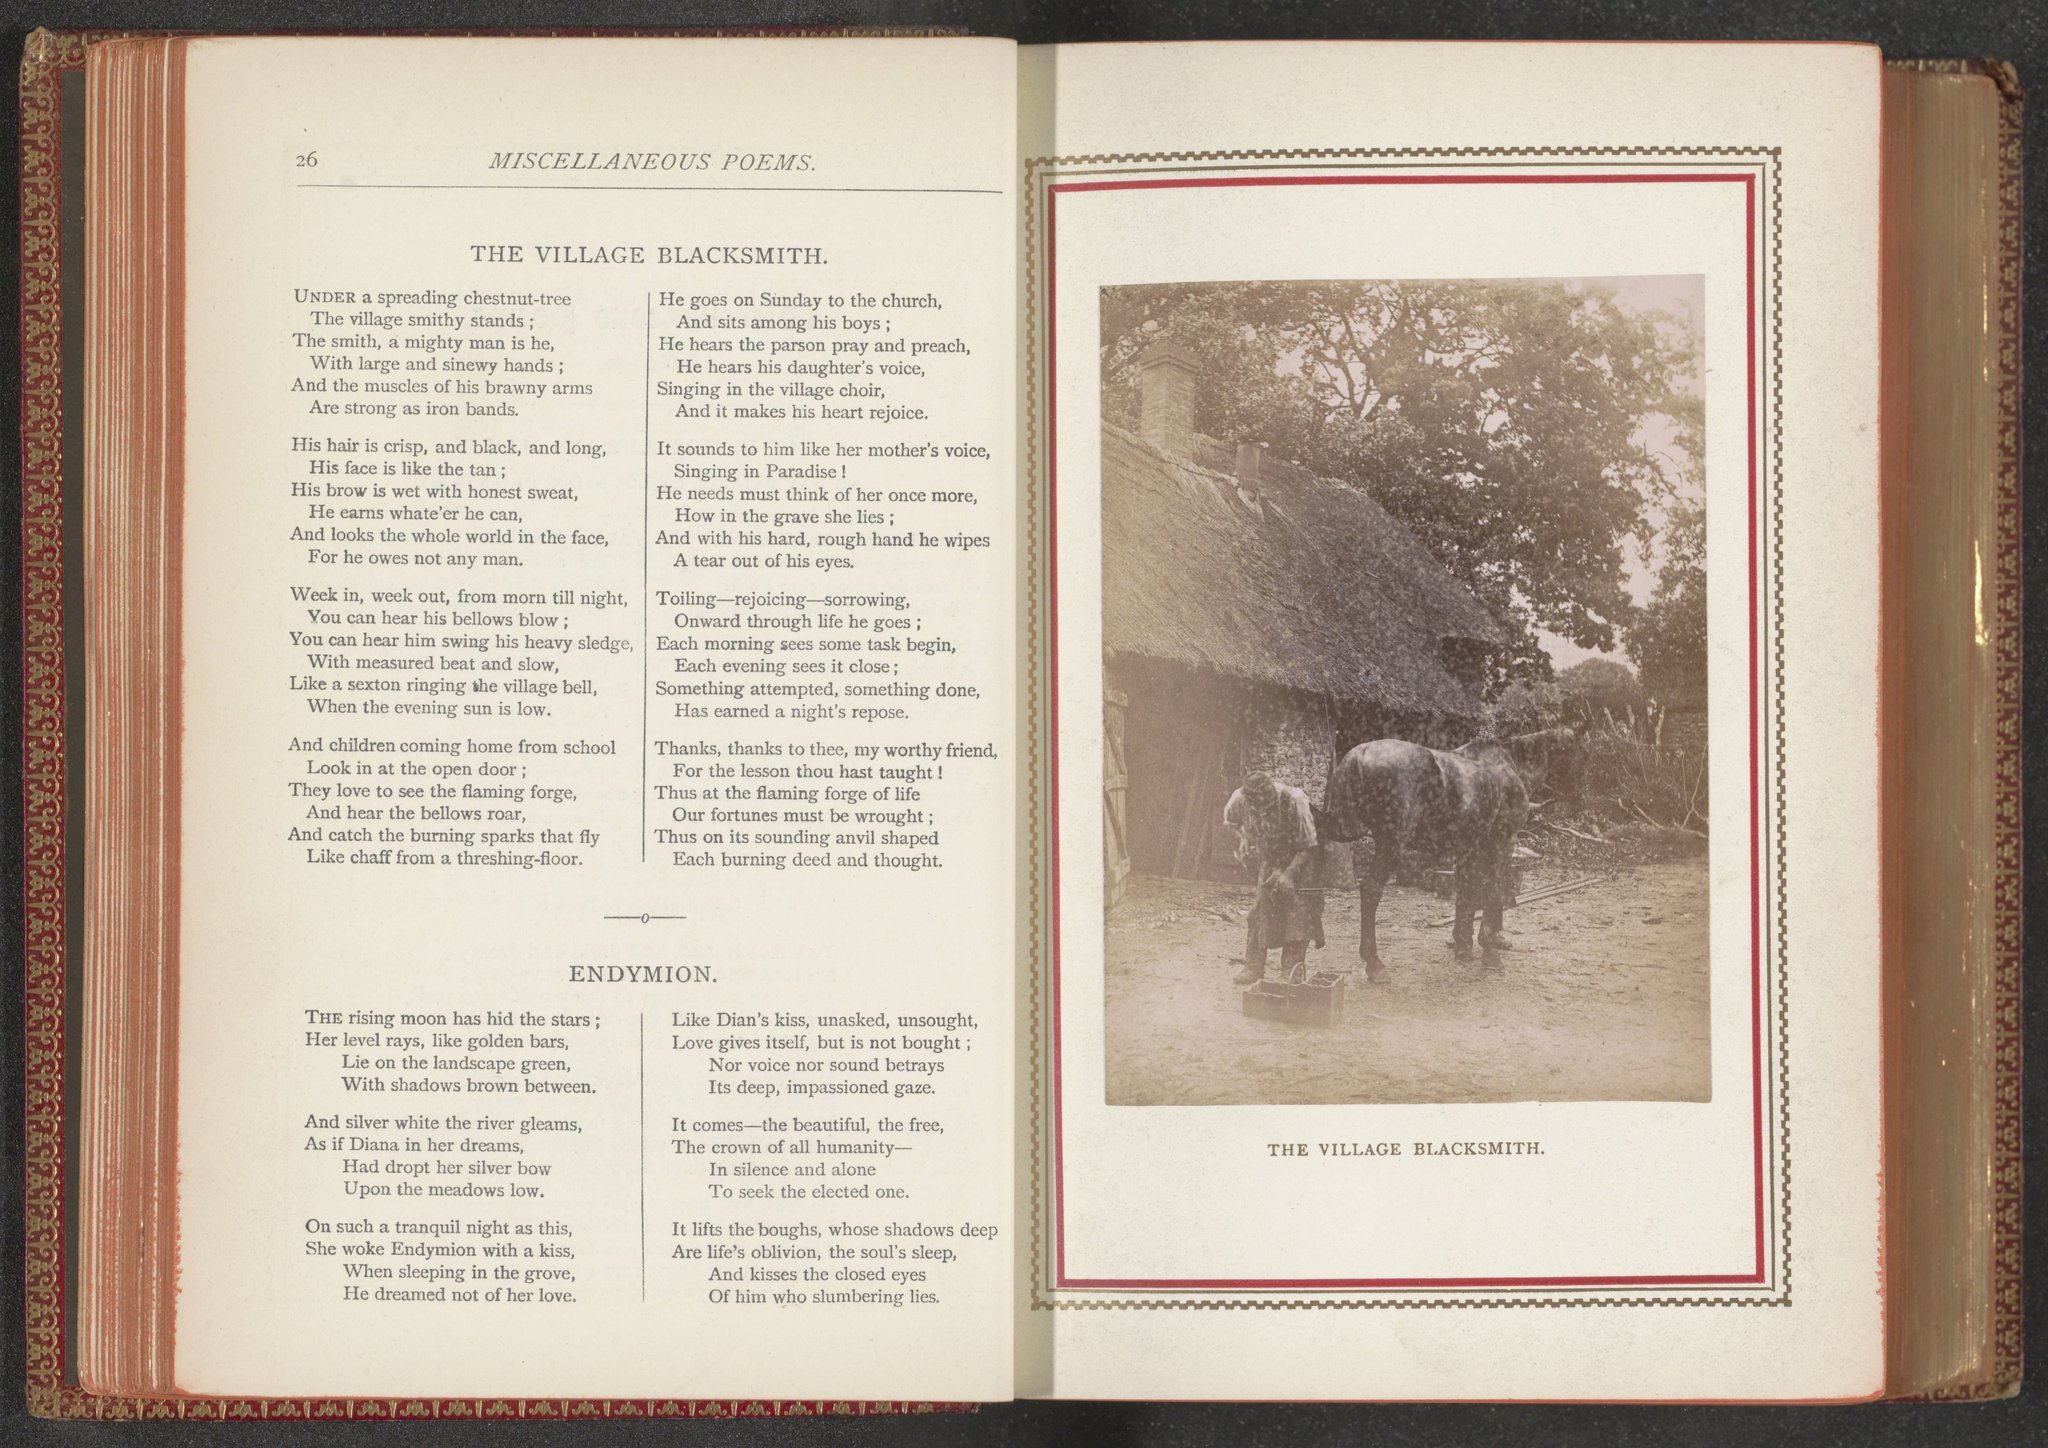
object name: page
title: Smid die aan de hoefijzers van een paard werkt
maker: Anonymous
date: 1872-1882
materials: photographic support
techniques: albumen print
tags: smith, blacksmith